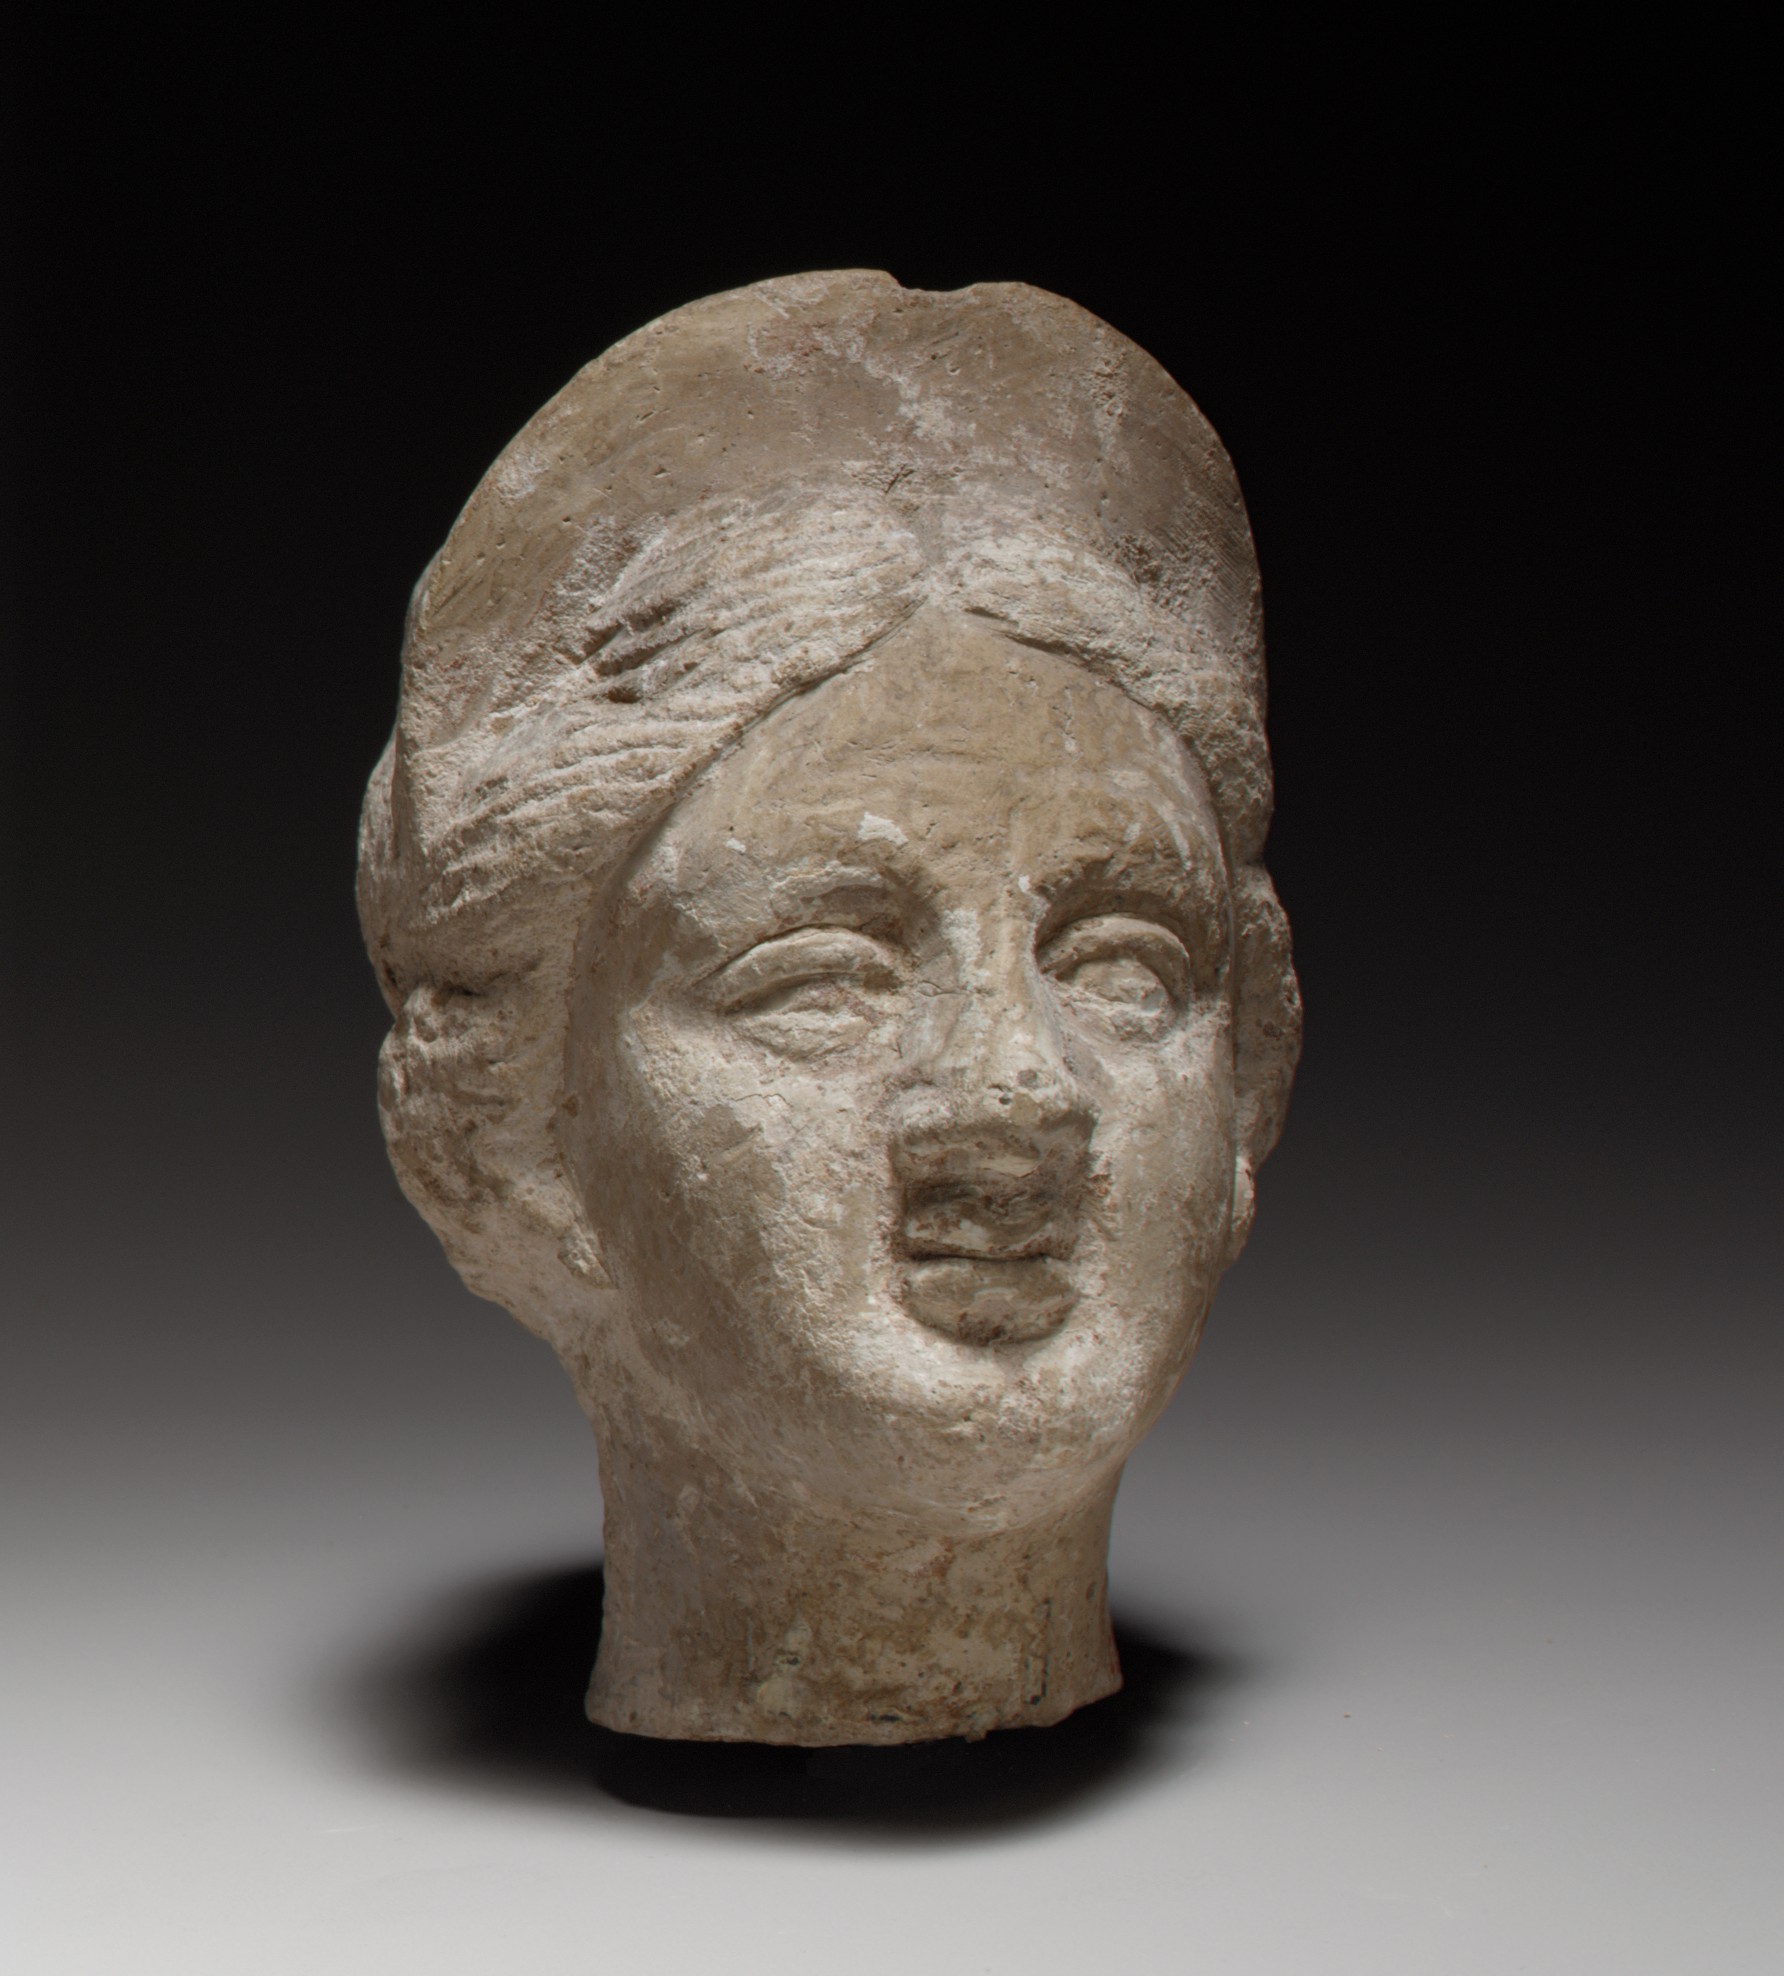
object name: head of a woman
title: Terracotta female head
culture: cypriot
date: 234-101 BCE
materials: terracotta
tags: heads,women